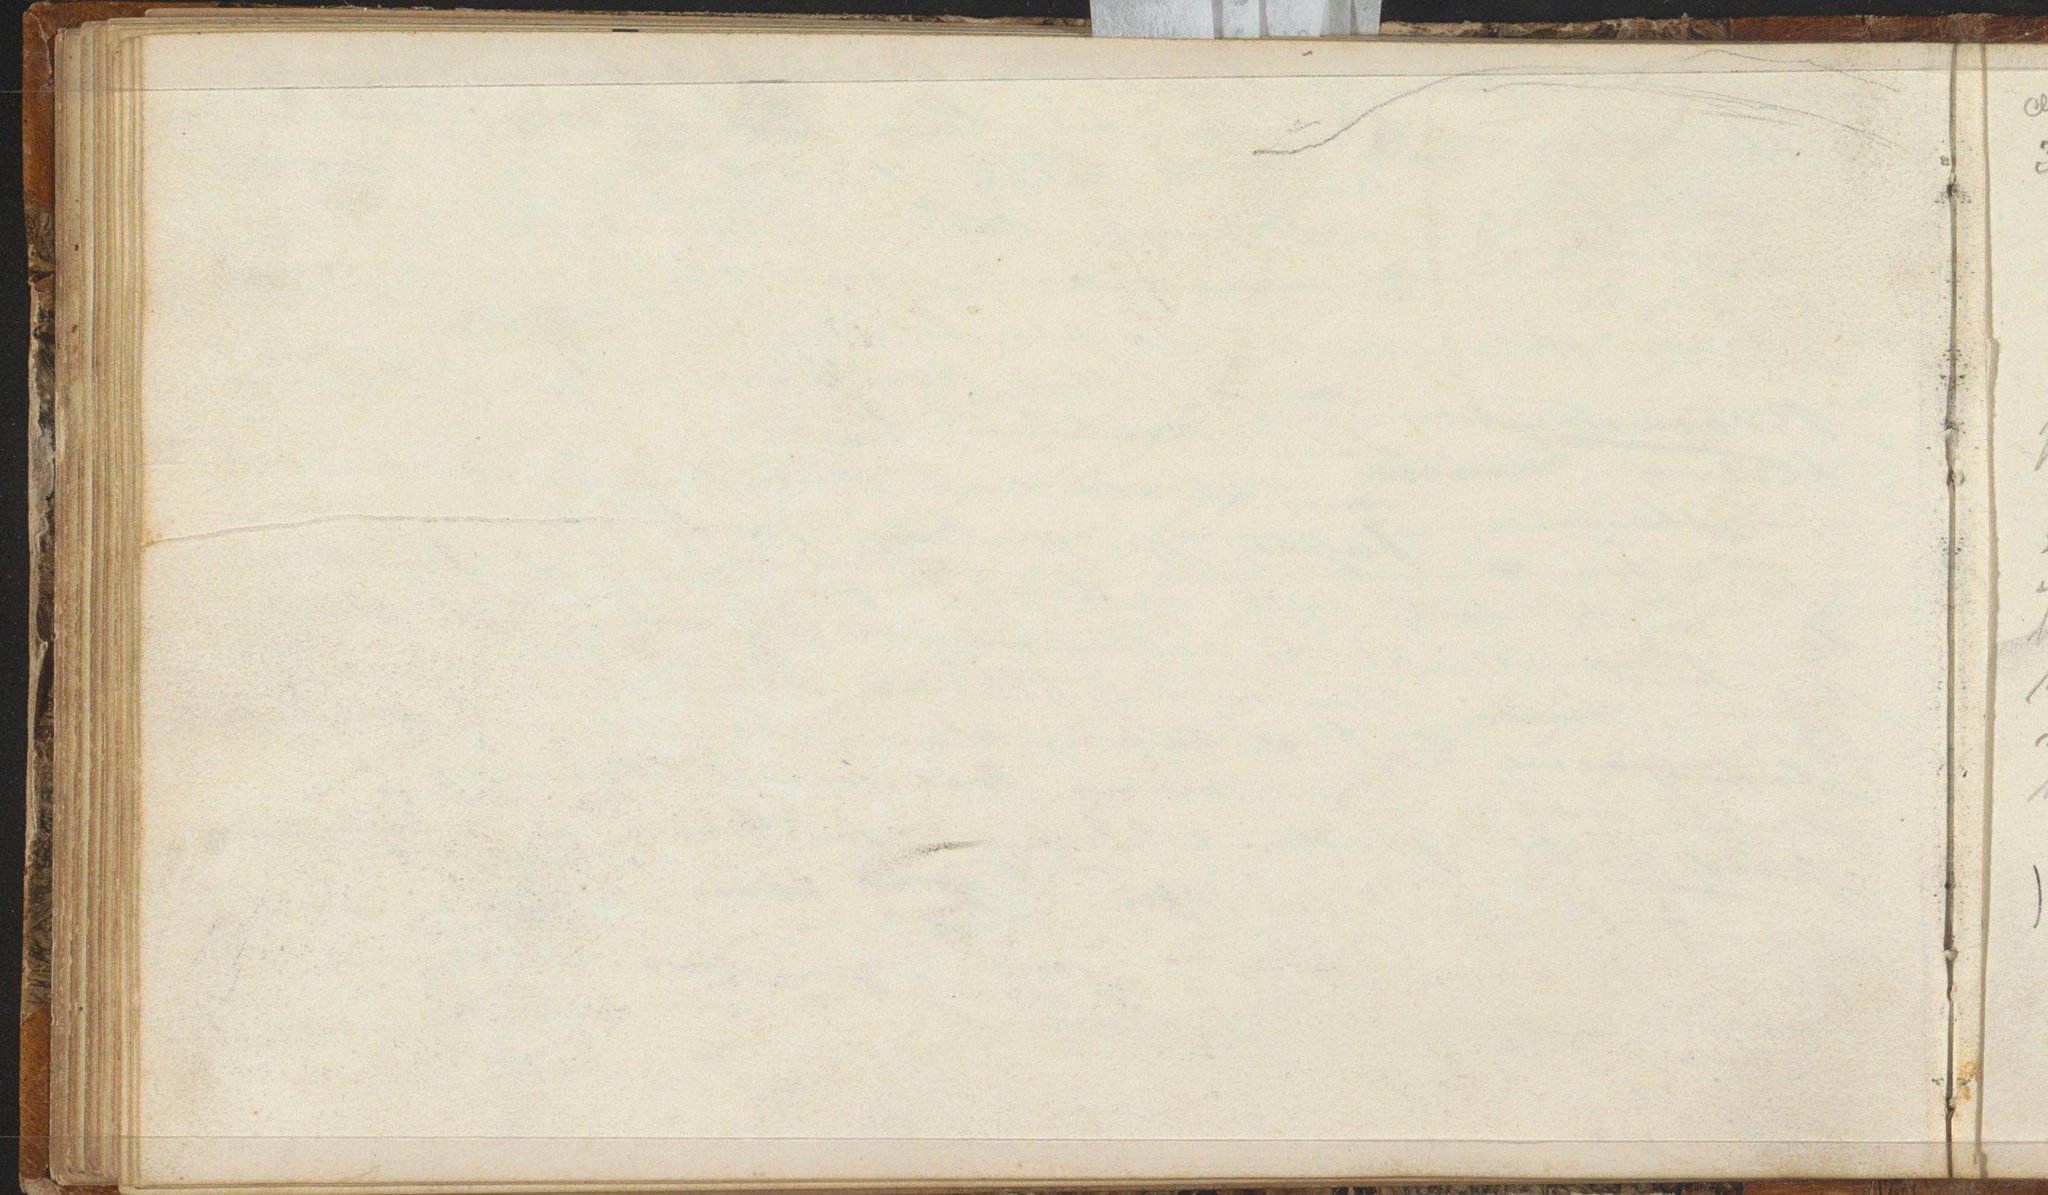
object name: sketchbook leaf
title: Studie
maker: johannes tavenraat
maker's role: draughtsman, painter, print maker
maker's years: 1809-1881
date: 1843-1844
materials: paper, pencil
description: Blad 36 verso uit een schetsboek met 38 bladen.